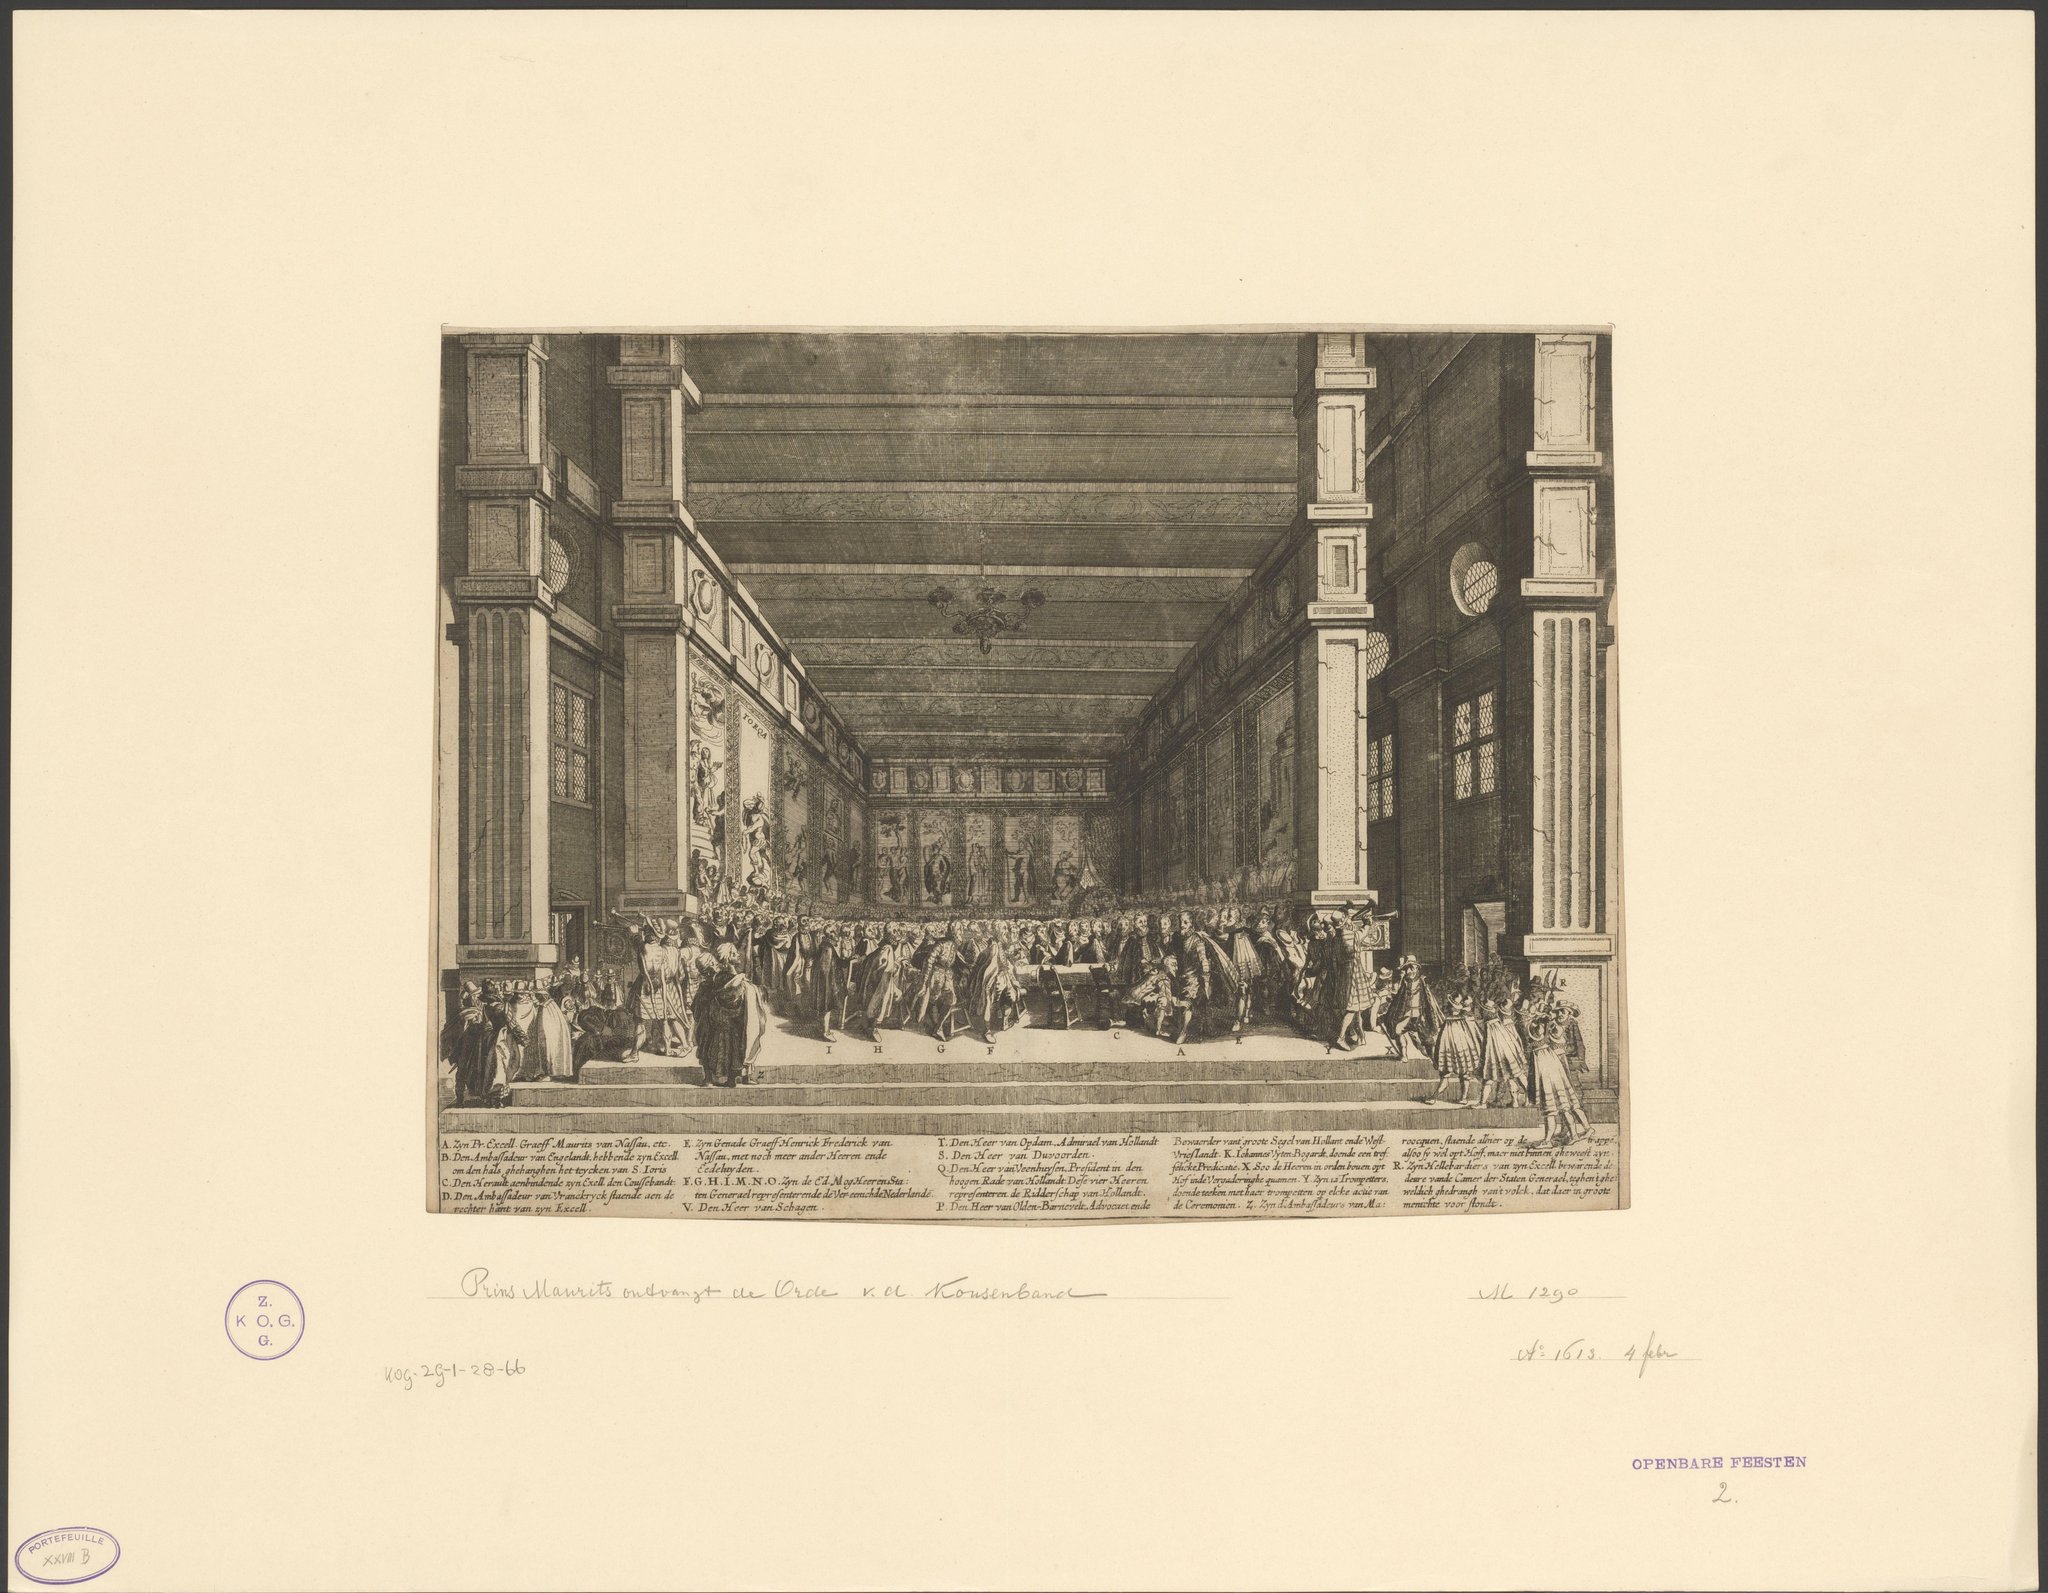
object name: print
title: Investituur van Maurits met de Orde van de Kousenband, 1613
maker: Anonymous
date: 1613-1615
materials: paper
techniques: engraving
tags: the hague, maurice (prince of orange), knighthood order, clothing (~ knighting ceremony)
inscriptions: stamp, stamp, collector's mark: Lugt 1641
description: De investituur van Maurits met de Orde van de Kousenband, 4 februari 1613. Maurits krijgt in de grote zaal van het Binnenhof te 's-Gravenhage door een heraut de kousenband omgedaan in aanwezigheid van de Engelse ambassadeur, Johan van Oldenbarnevelt, de leden van de Staten-Generaal en vele andere gasten. Onderaan een legenda van A-R. Onderwerpsrubrieken binnen de Atlas Zeden en Gewoonten: Zeden en Gewoonten in Engeren Zin. Volksleven. Openbare feesten. Vorstelijke intochten, (Illuminaties, vuurwerken en dergelijke, openbare feesten).